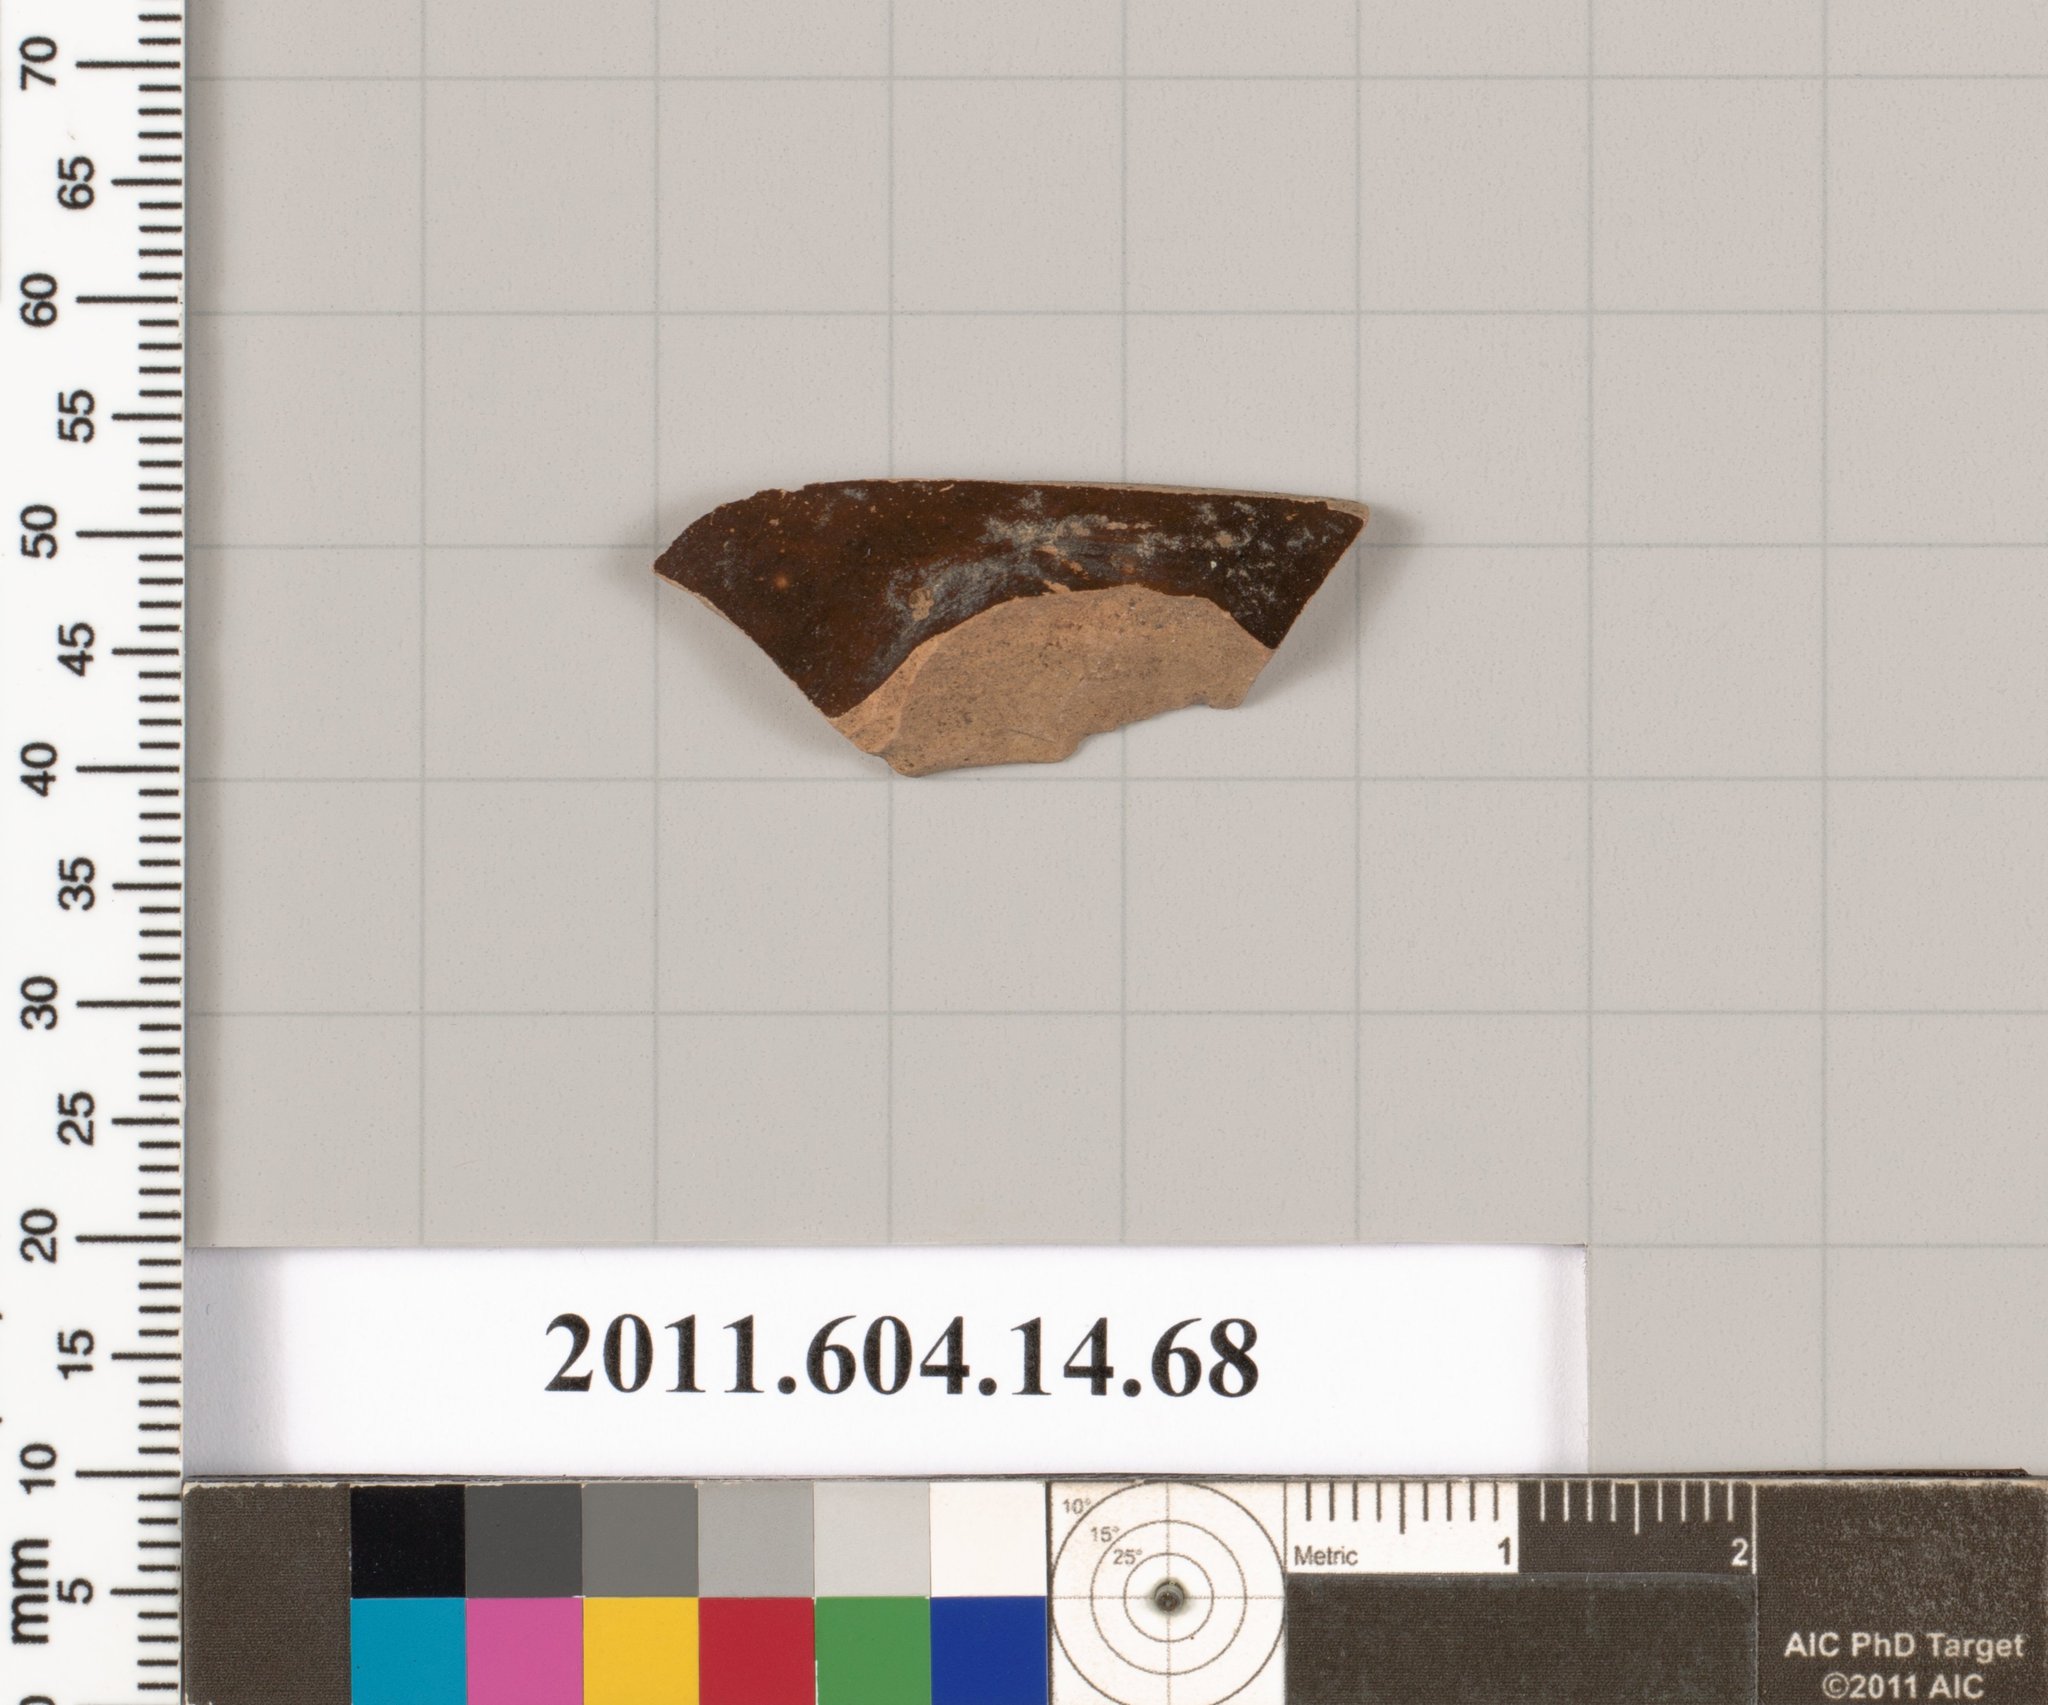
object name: kylix fragment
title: Terracotta fragment of a kylix (drinking cup)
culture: unknown fabric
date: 600-401 BCE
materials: terracotta